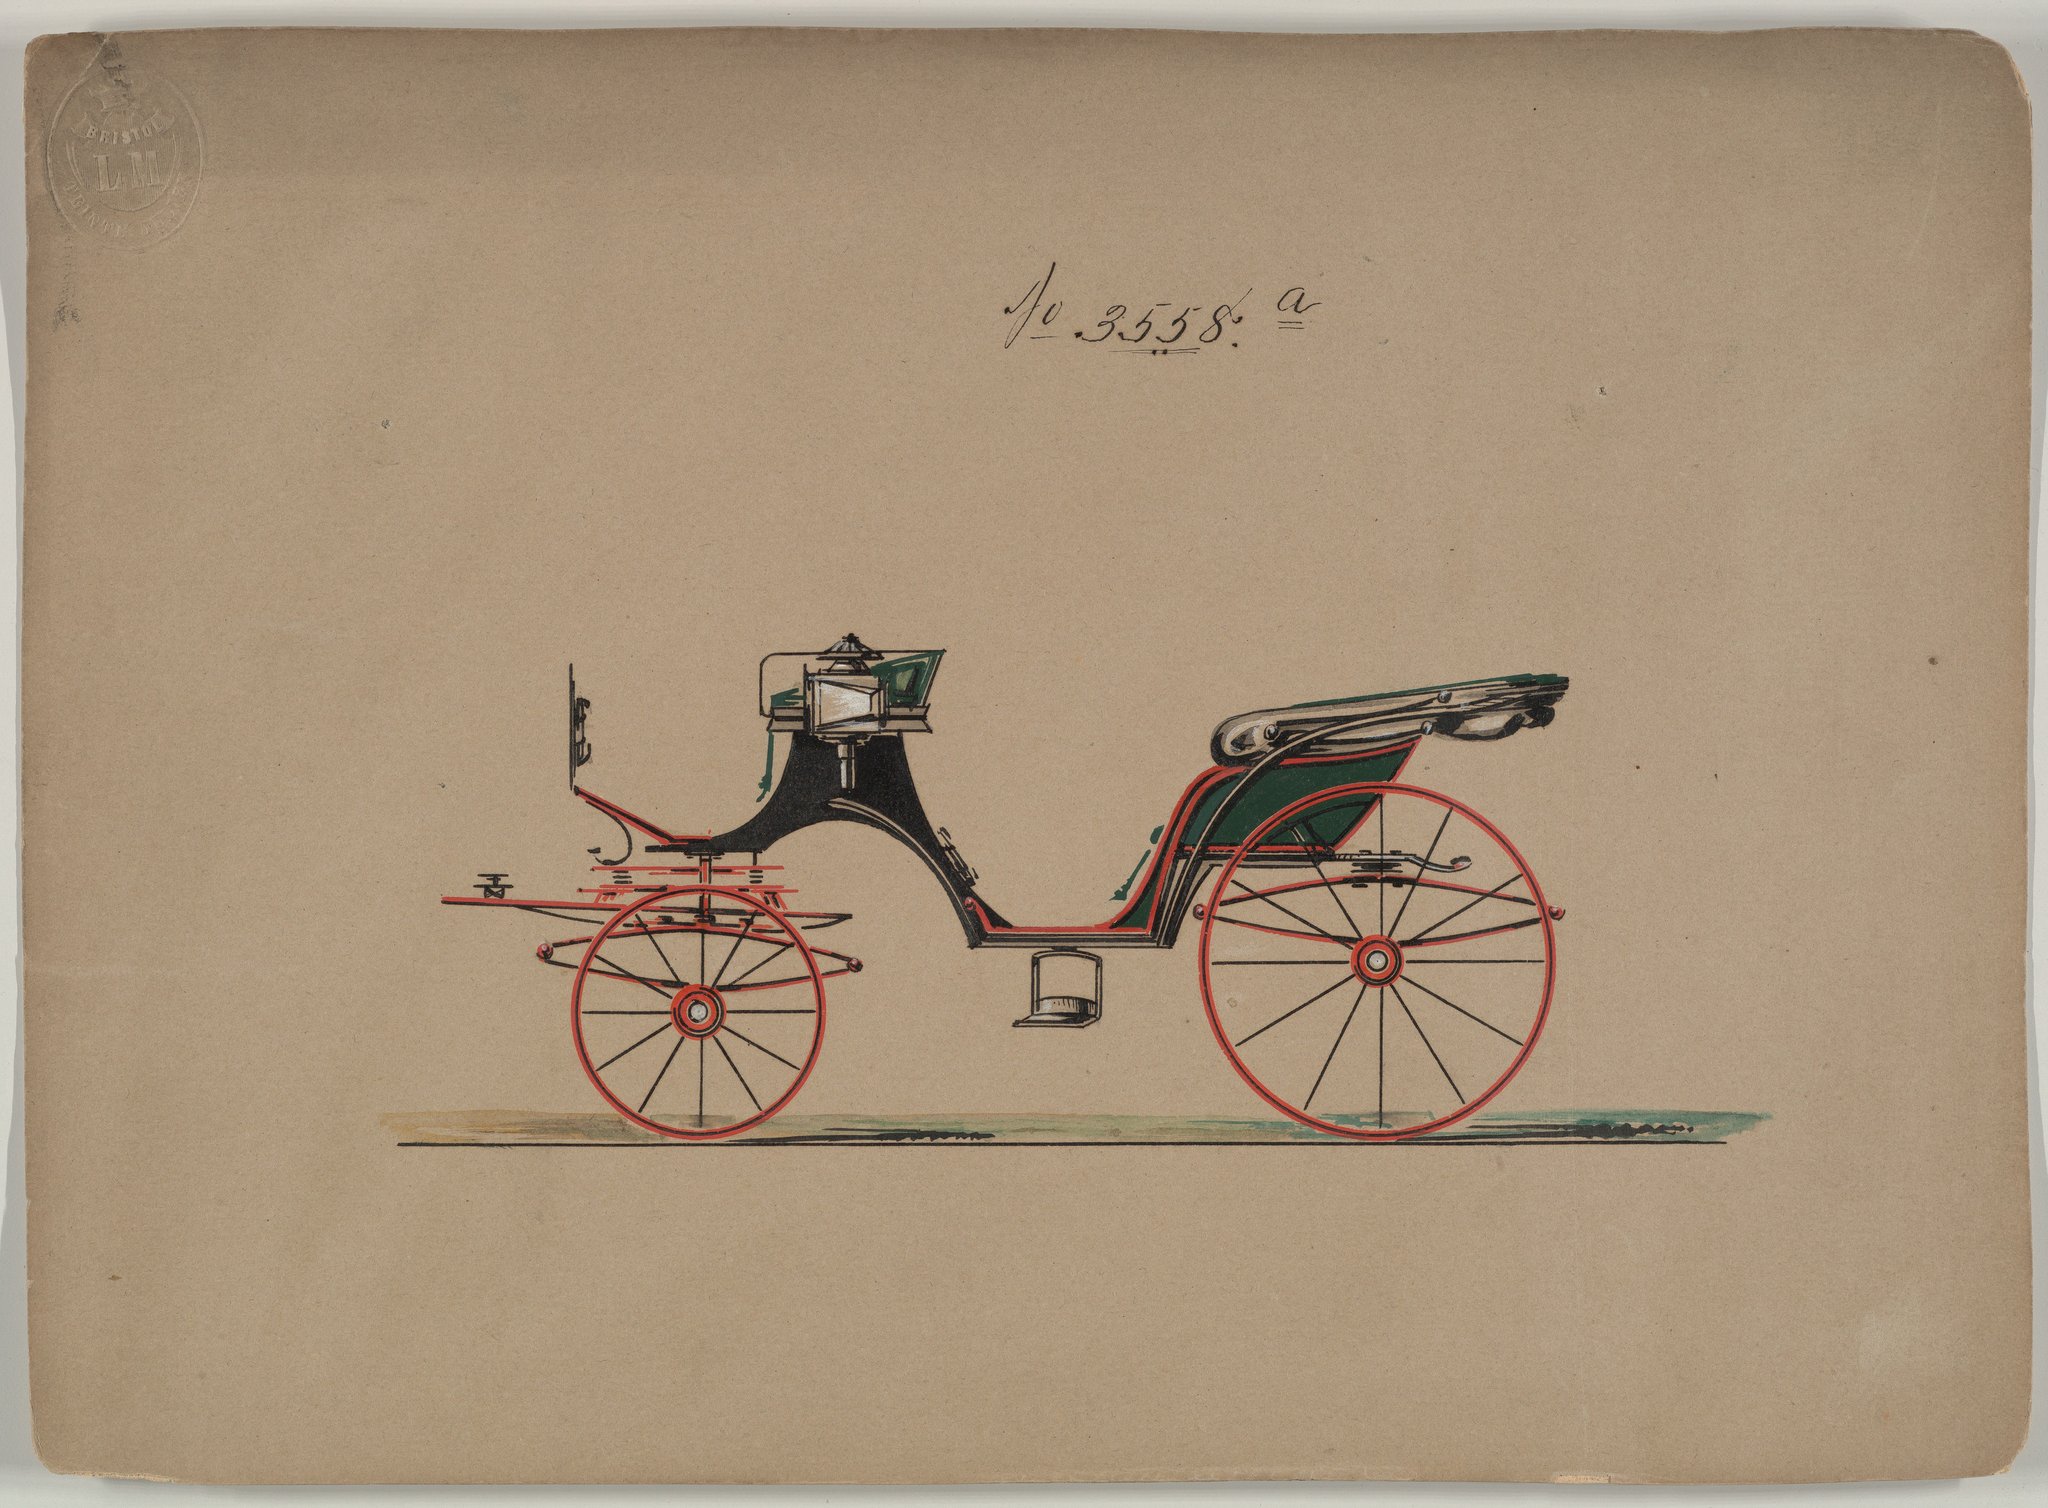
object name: drawing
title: Design for Cabriolet or Victoria, no. 3558a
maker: brewster & co.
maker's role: manufacturer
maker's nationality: american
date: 1879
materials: gouache, ink, watercolor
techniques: pen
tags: carriages